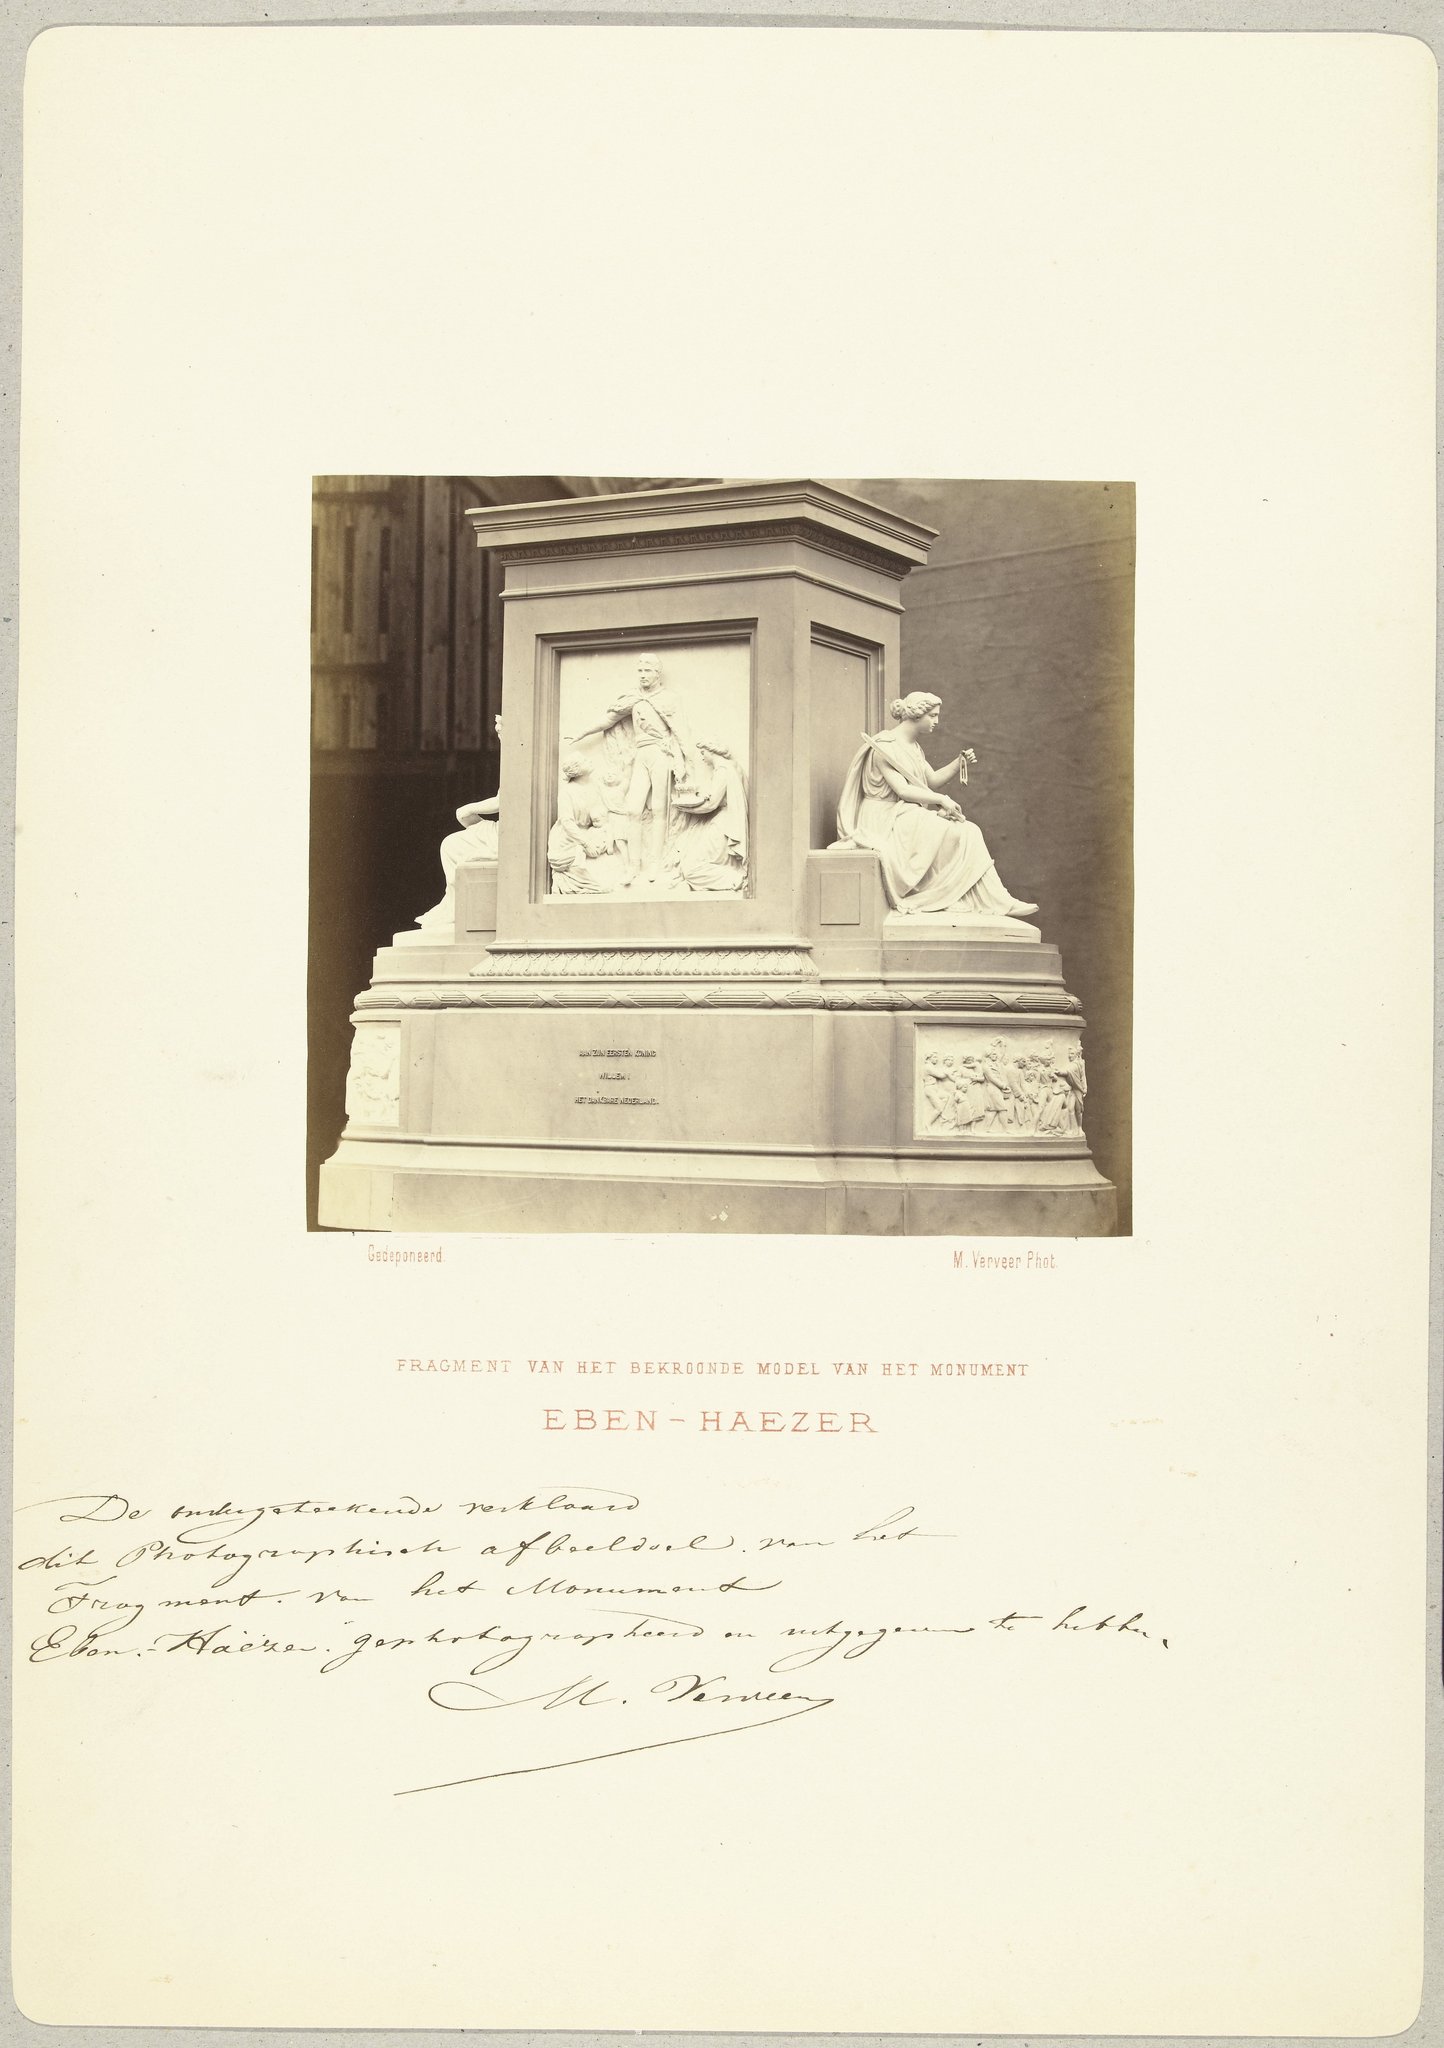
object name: photograph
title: Fragment van het bekroonde model van het monument Eben-Haezer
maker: maurits verveer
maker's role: painter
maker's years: 1817-1903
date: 1864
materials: cardboard, paper, photographic support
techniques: albumen print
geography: the hague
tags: piece of sculpture, reproduction of a piece of sculpture, monument, statue, the hague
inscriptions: annotation: ‘De ondergetekende verklaard dit photographisch afbeeldsel van het fragment van het bekroond monument Eben-Haezer gephotographeerd en uitgegeven te hebben M. Verveer’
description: Fragment van het bekroond ontwerp voor het Nationaal Monument 1813-1863 [motto Eben-Haezer] in Den Haag, van J.Ph. Koelman en W.C. van der Waeyen Pietersen